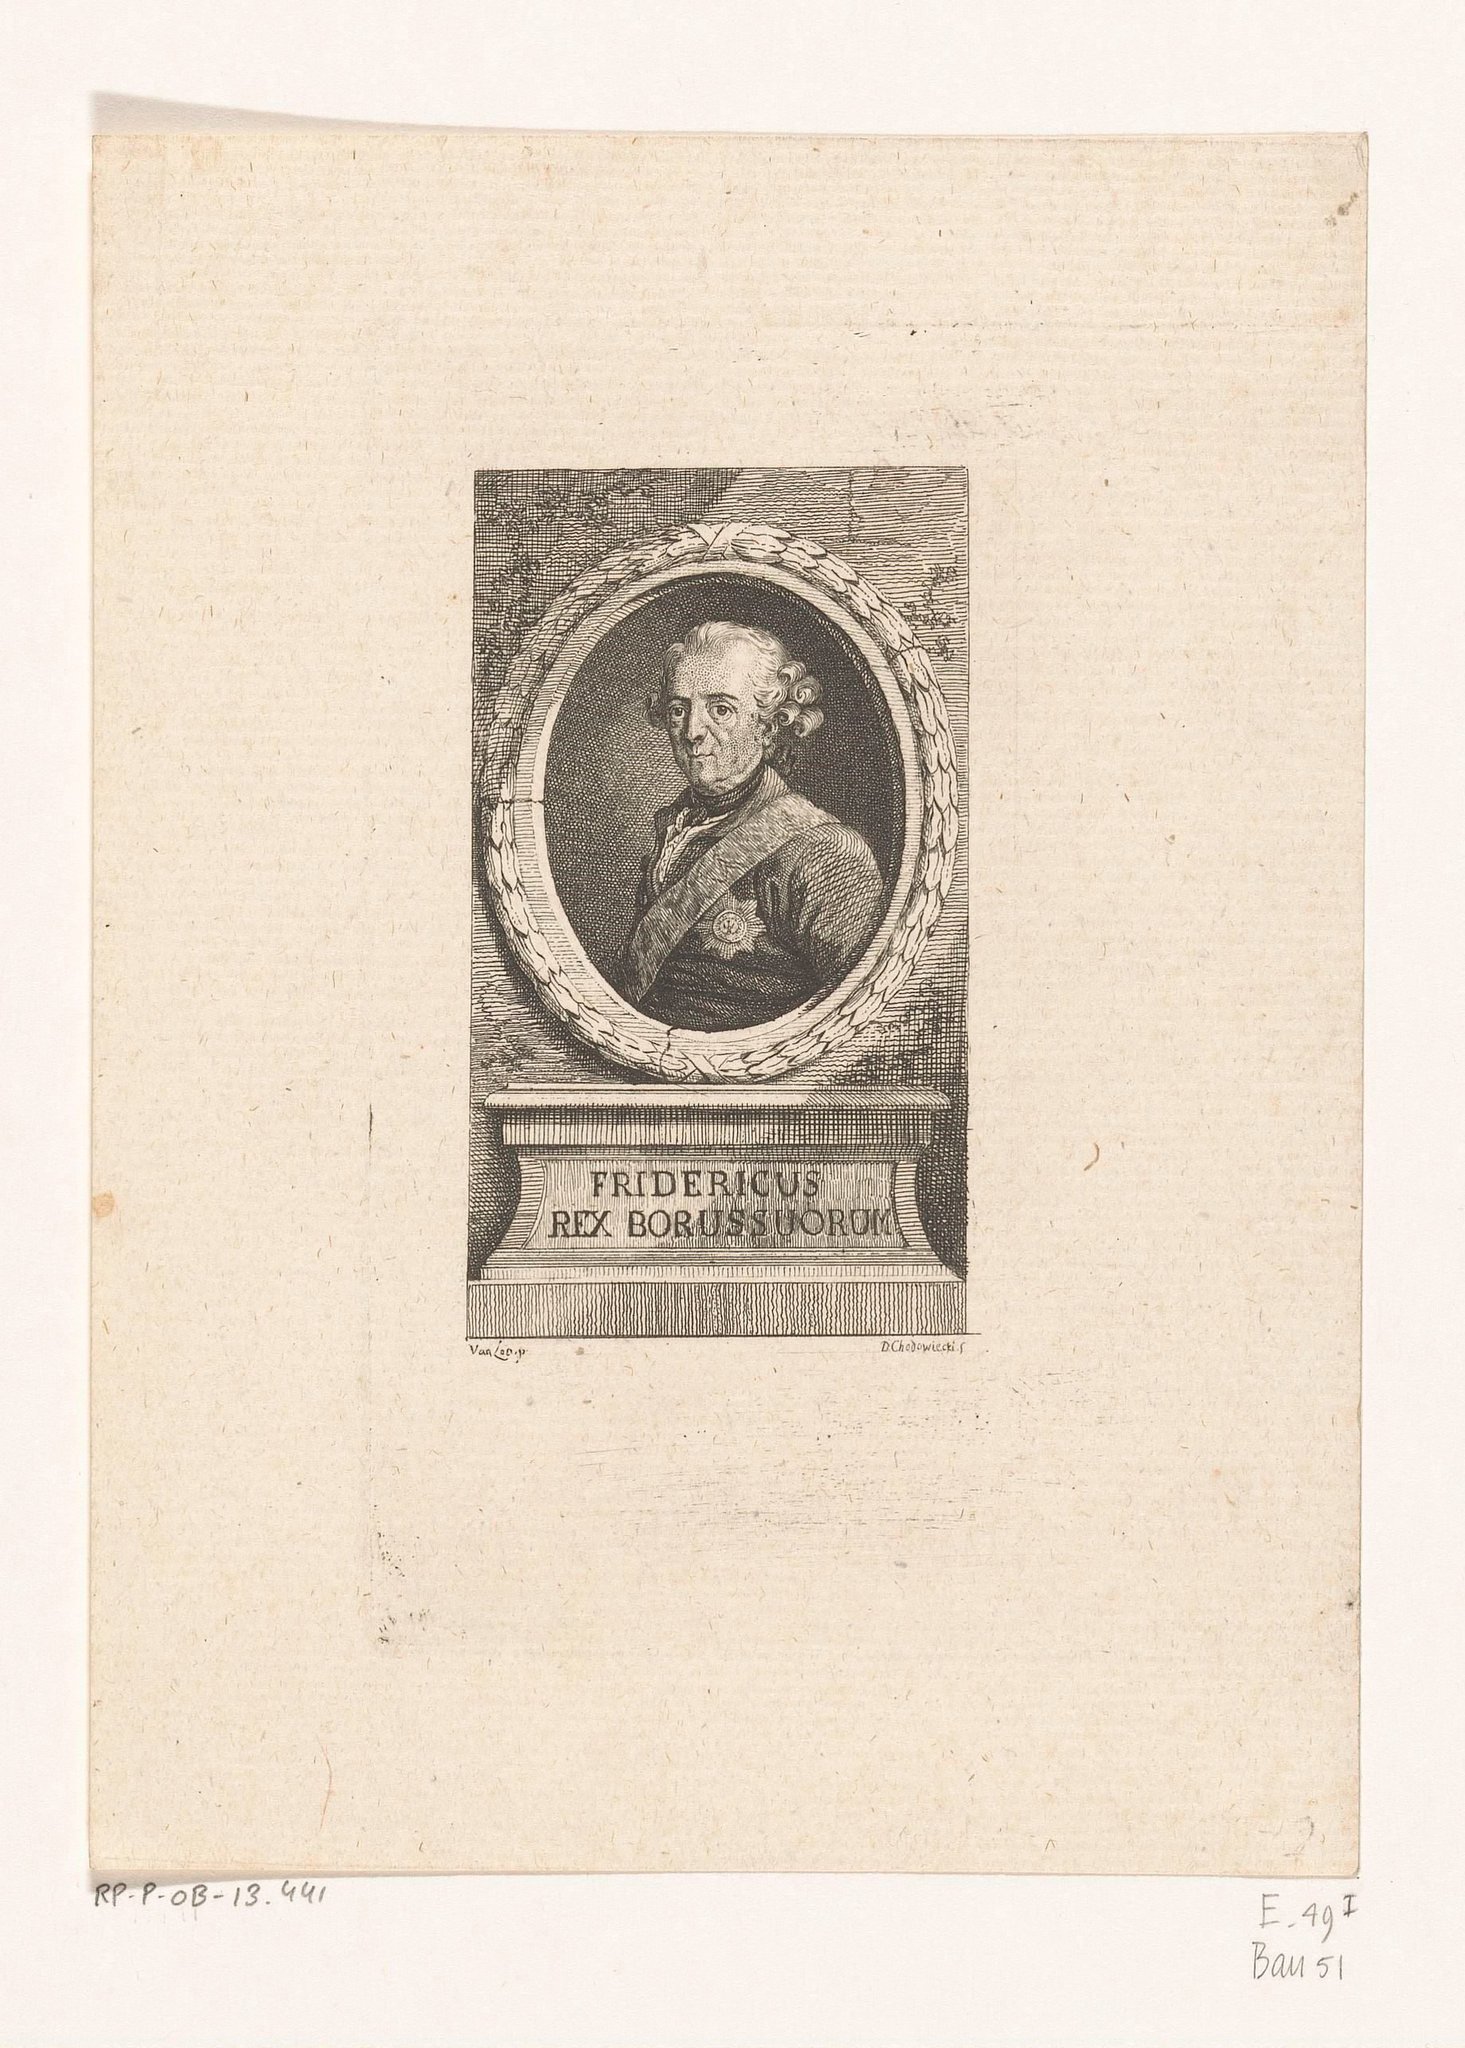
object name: print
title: Portret van Frederik de Grote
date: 1768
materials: paper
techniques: etching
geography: berlin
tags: frederick ii (king of prussia), knighthood order (with name) - insignia of a knighthood order, e.g.: badge, chain (with name of order), historical persons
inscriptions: collector's mark: Lugt 2228